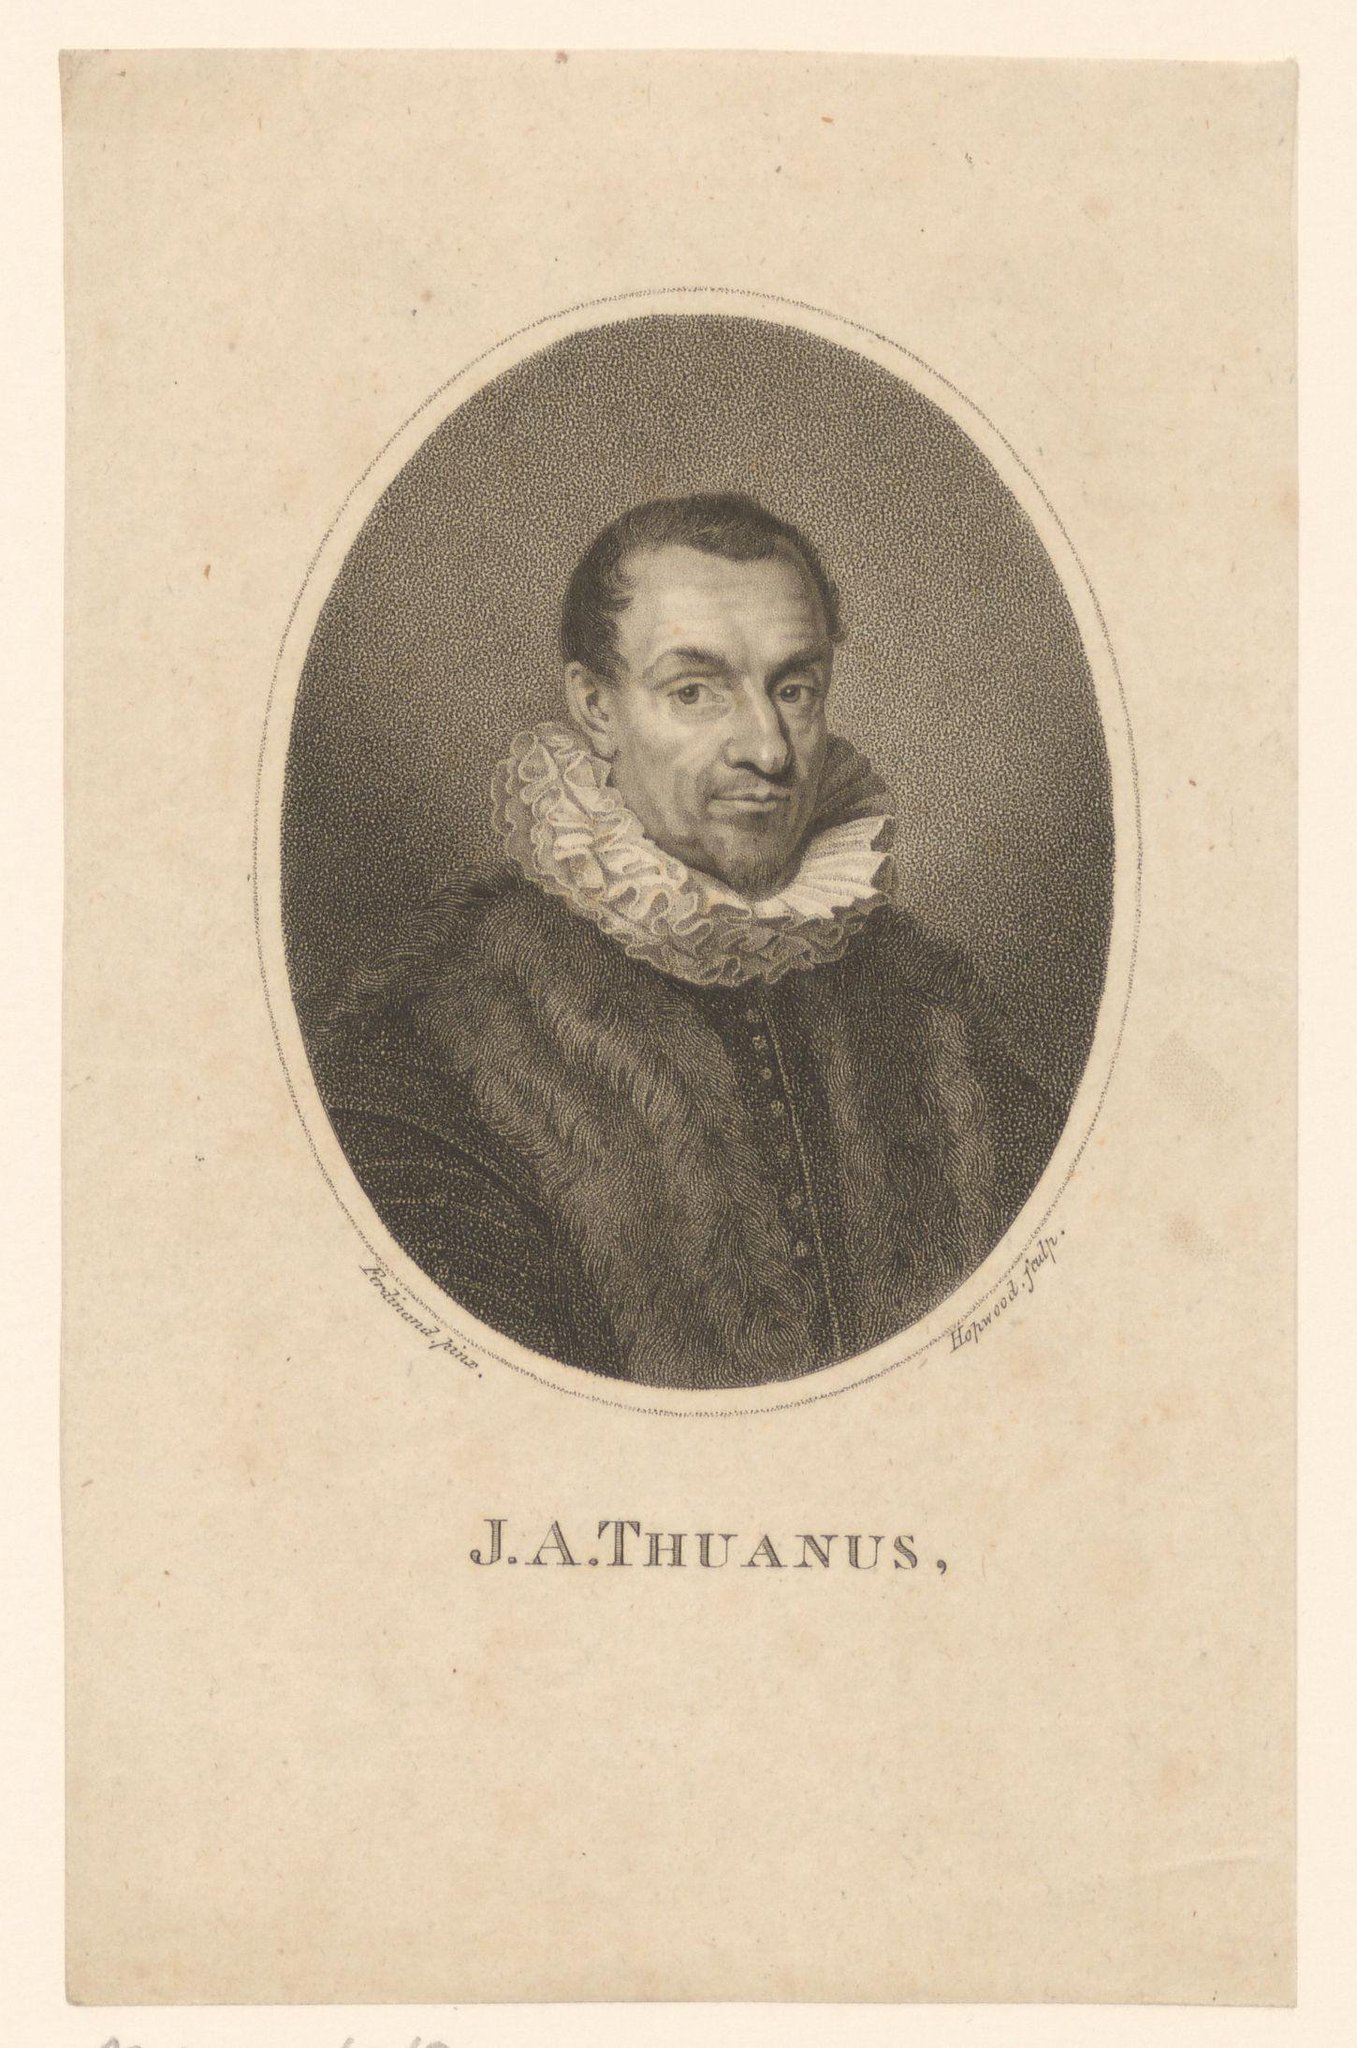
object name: print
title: Portret van Jacques-Auguste de Thou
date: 1762-1819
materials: paper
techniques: etching, engraving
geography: england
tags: paris, politician, historical persons, politician, e.g. party leader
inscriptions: collector's mark: Lugt 2228